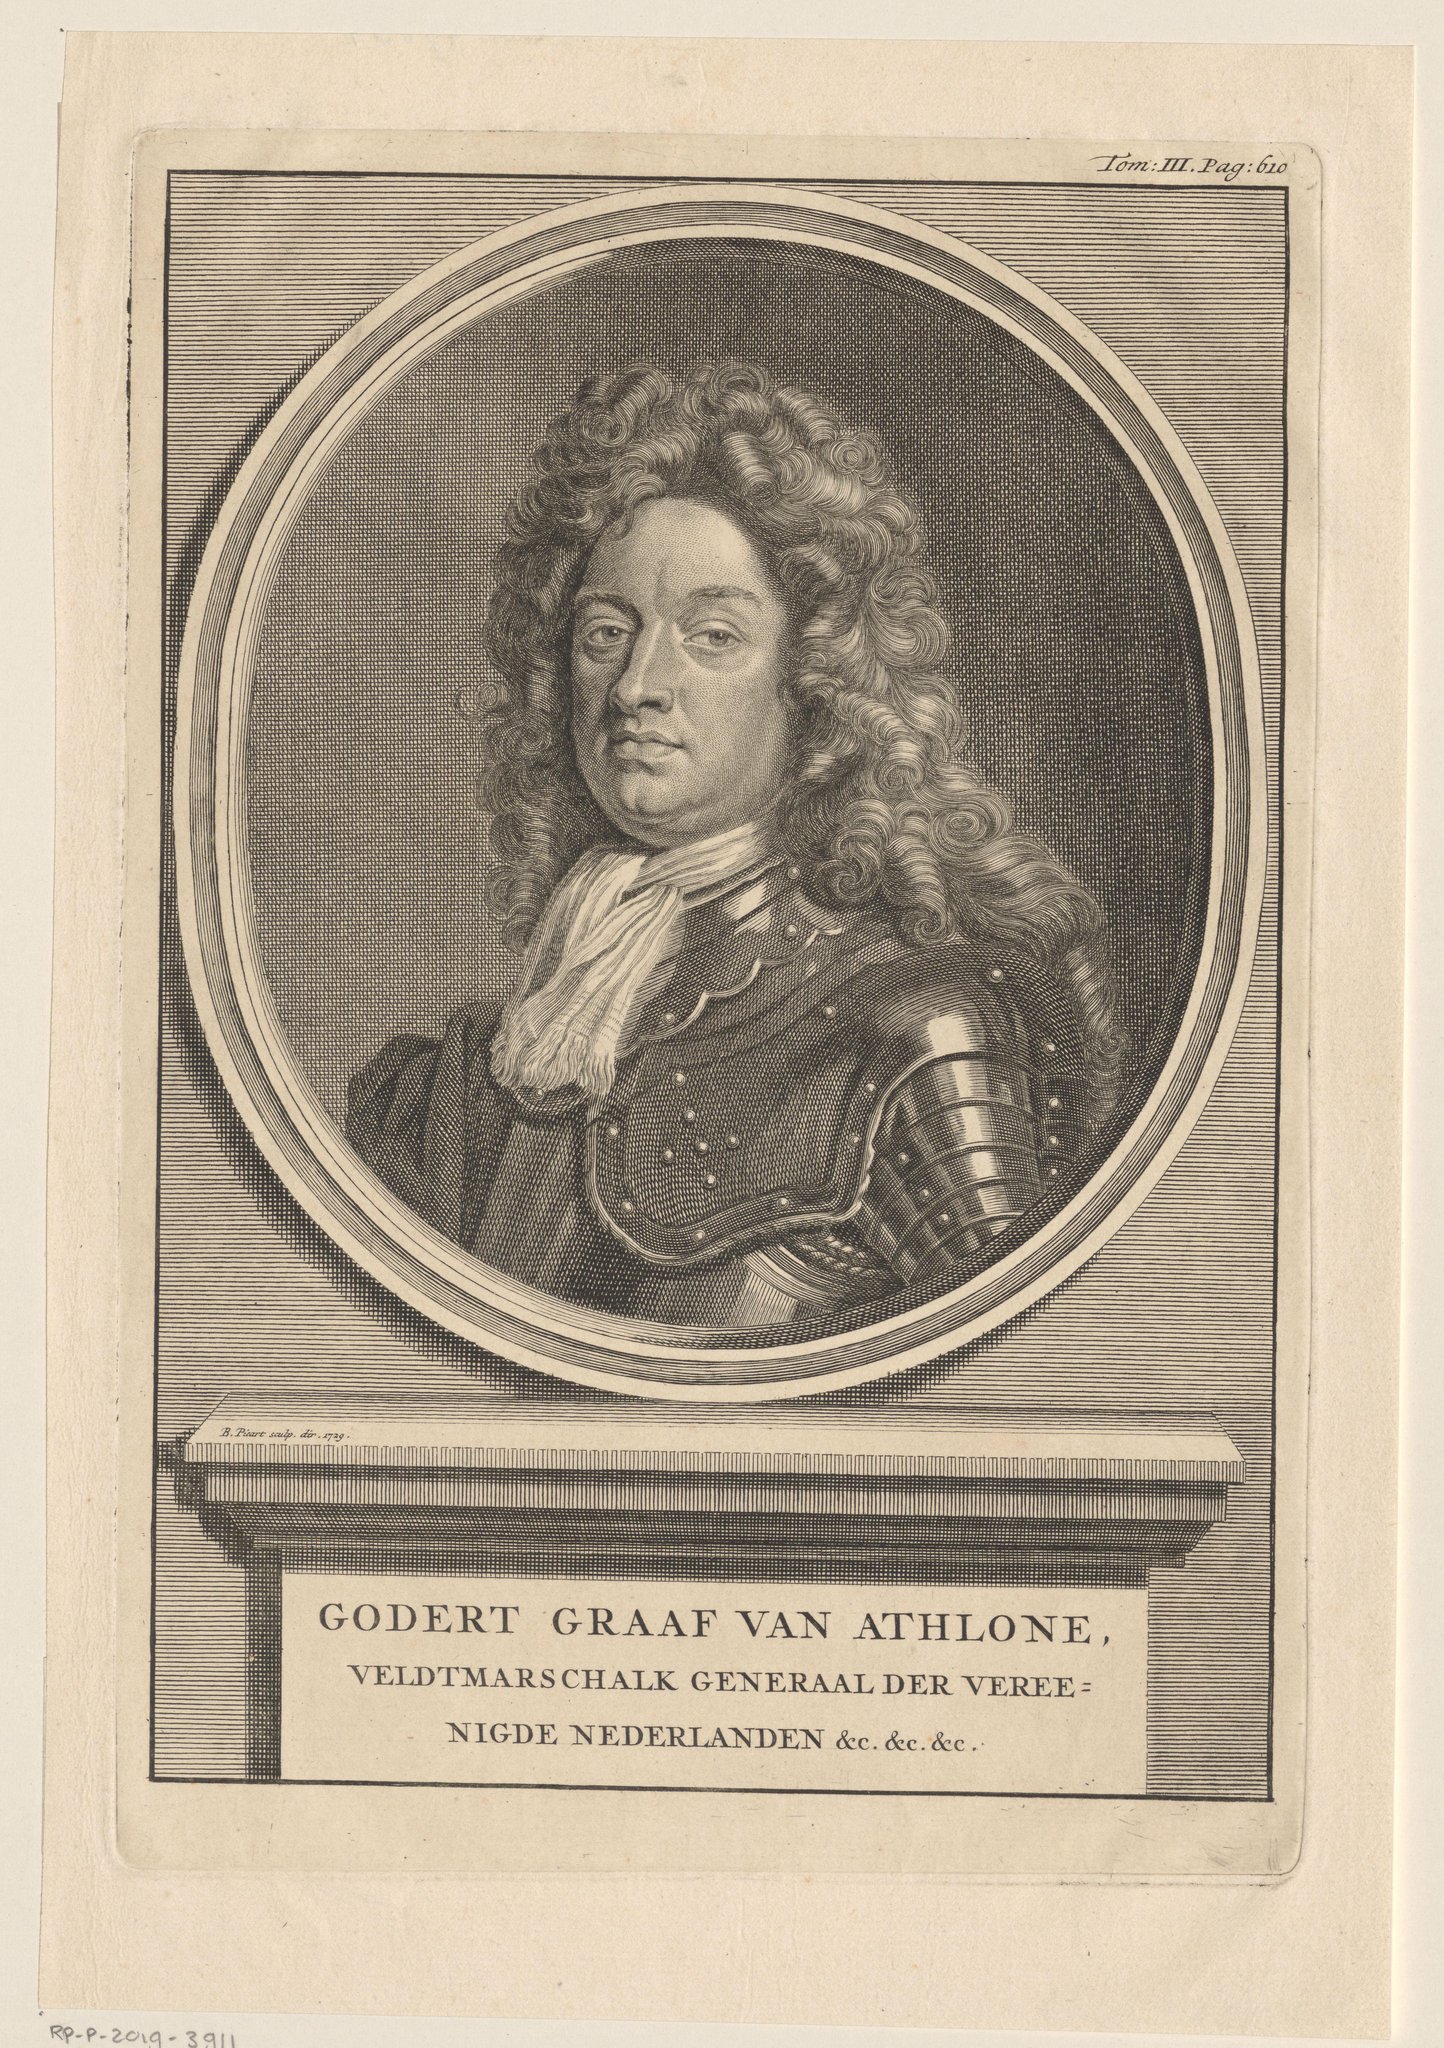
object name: book illustration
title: Portret van Godard, baron van Reede-Ginckel, graaf van Athlone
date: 1729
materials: paper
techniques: engraving, etching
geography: amsterdam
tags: utrecht, godard baron van reede-ginckel (graaf van athlone), armour, historical persons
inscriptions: date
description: Prent uit: Clerc, Jean le. Geschiedenissen der Vereenigde Nederlanden. Amsterdam: Zacharias Chatelain (II), 1730, dl. 3, p. 610.